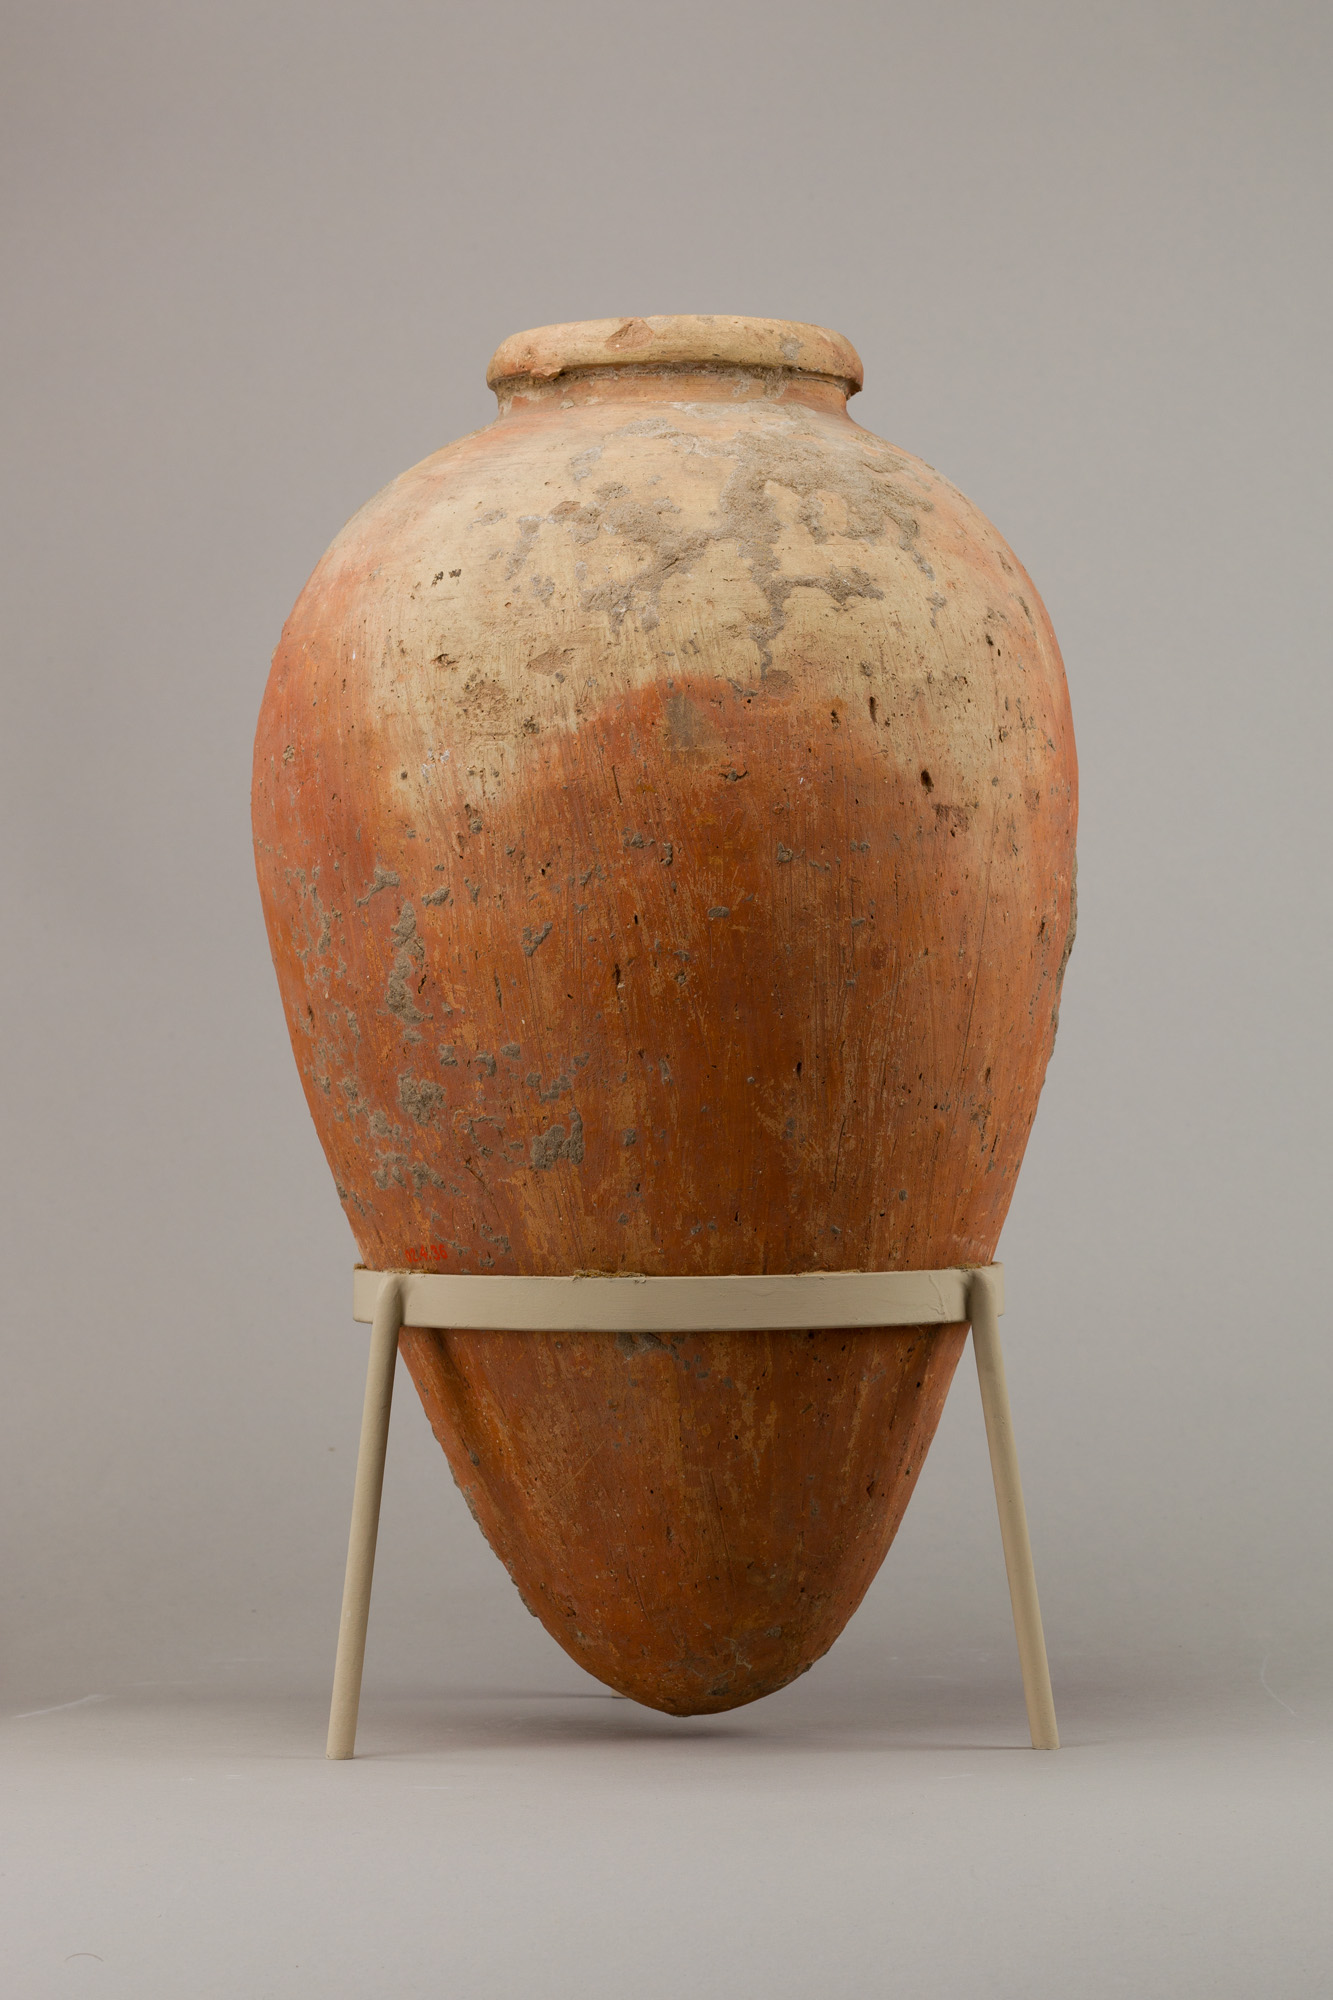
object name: jar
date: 3100-2649 BCE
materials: pottery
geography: egypt